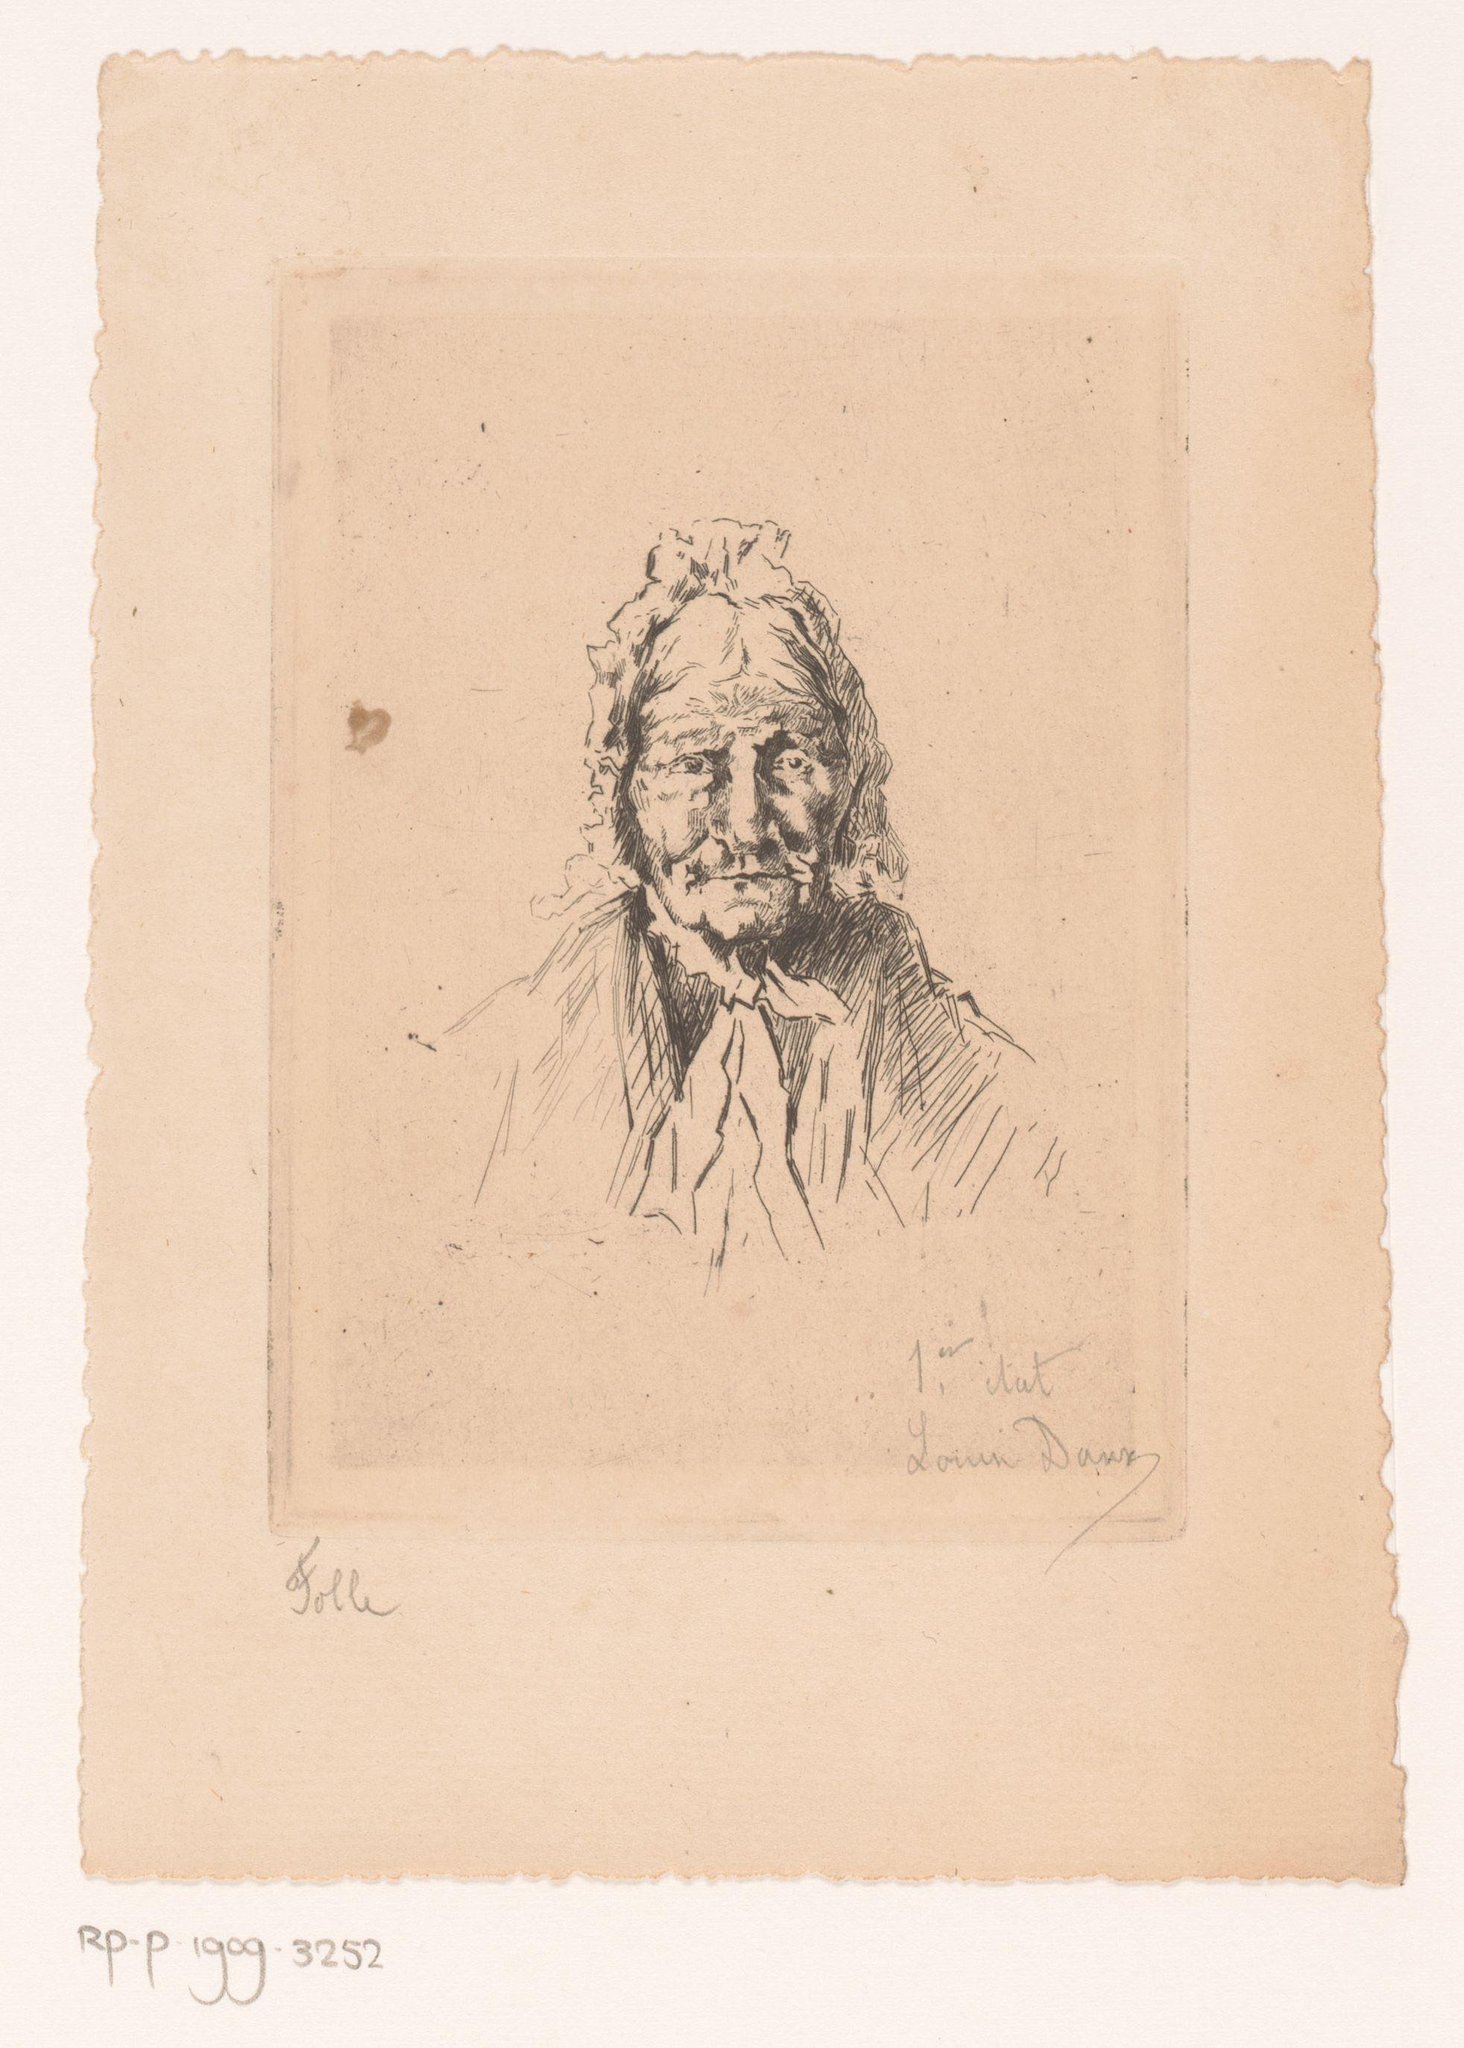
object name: print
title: Portret van een onbekende oude vrouw met muts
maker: louise danse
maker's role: painter, print maker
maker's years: 1867-1948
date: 1877-1909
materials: paper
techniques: etching, intaglio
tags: head-gear: cap (+ women's clothes), anonymous historical person portrayed - bb - woman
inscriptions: annotation: ‘1er état’, collector's mark: Lugt 2228